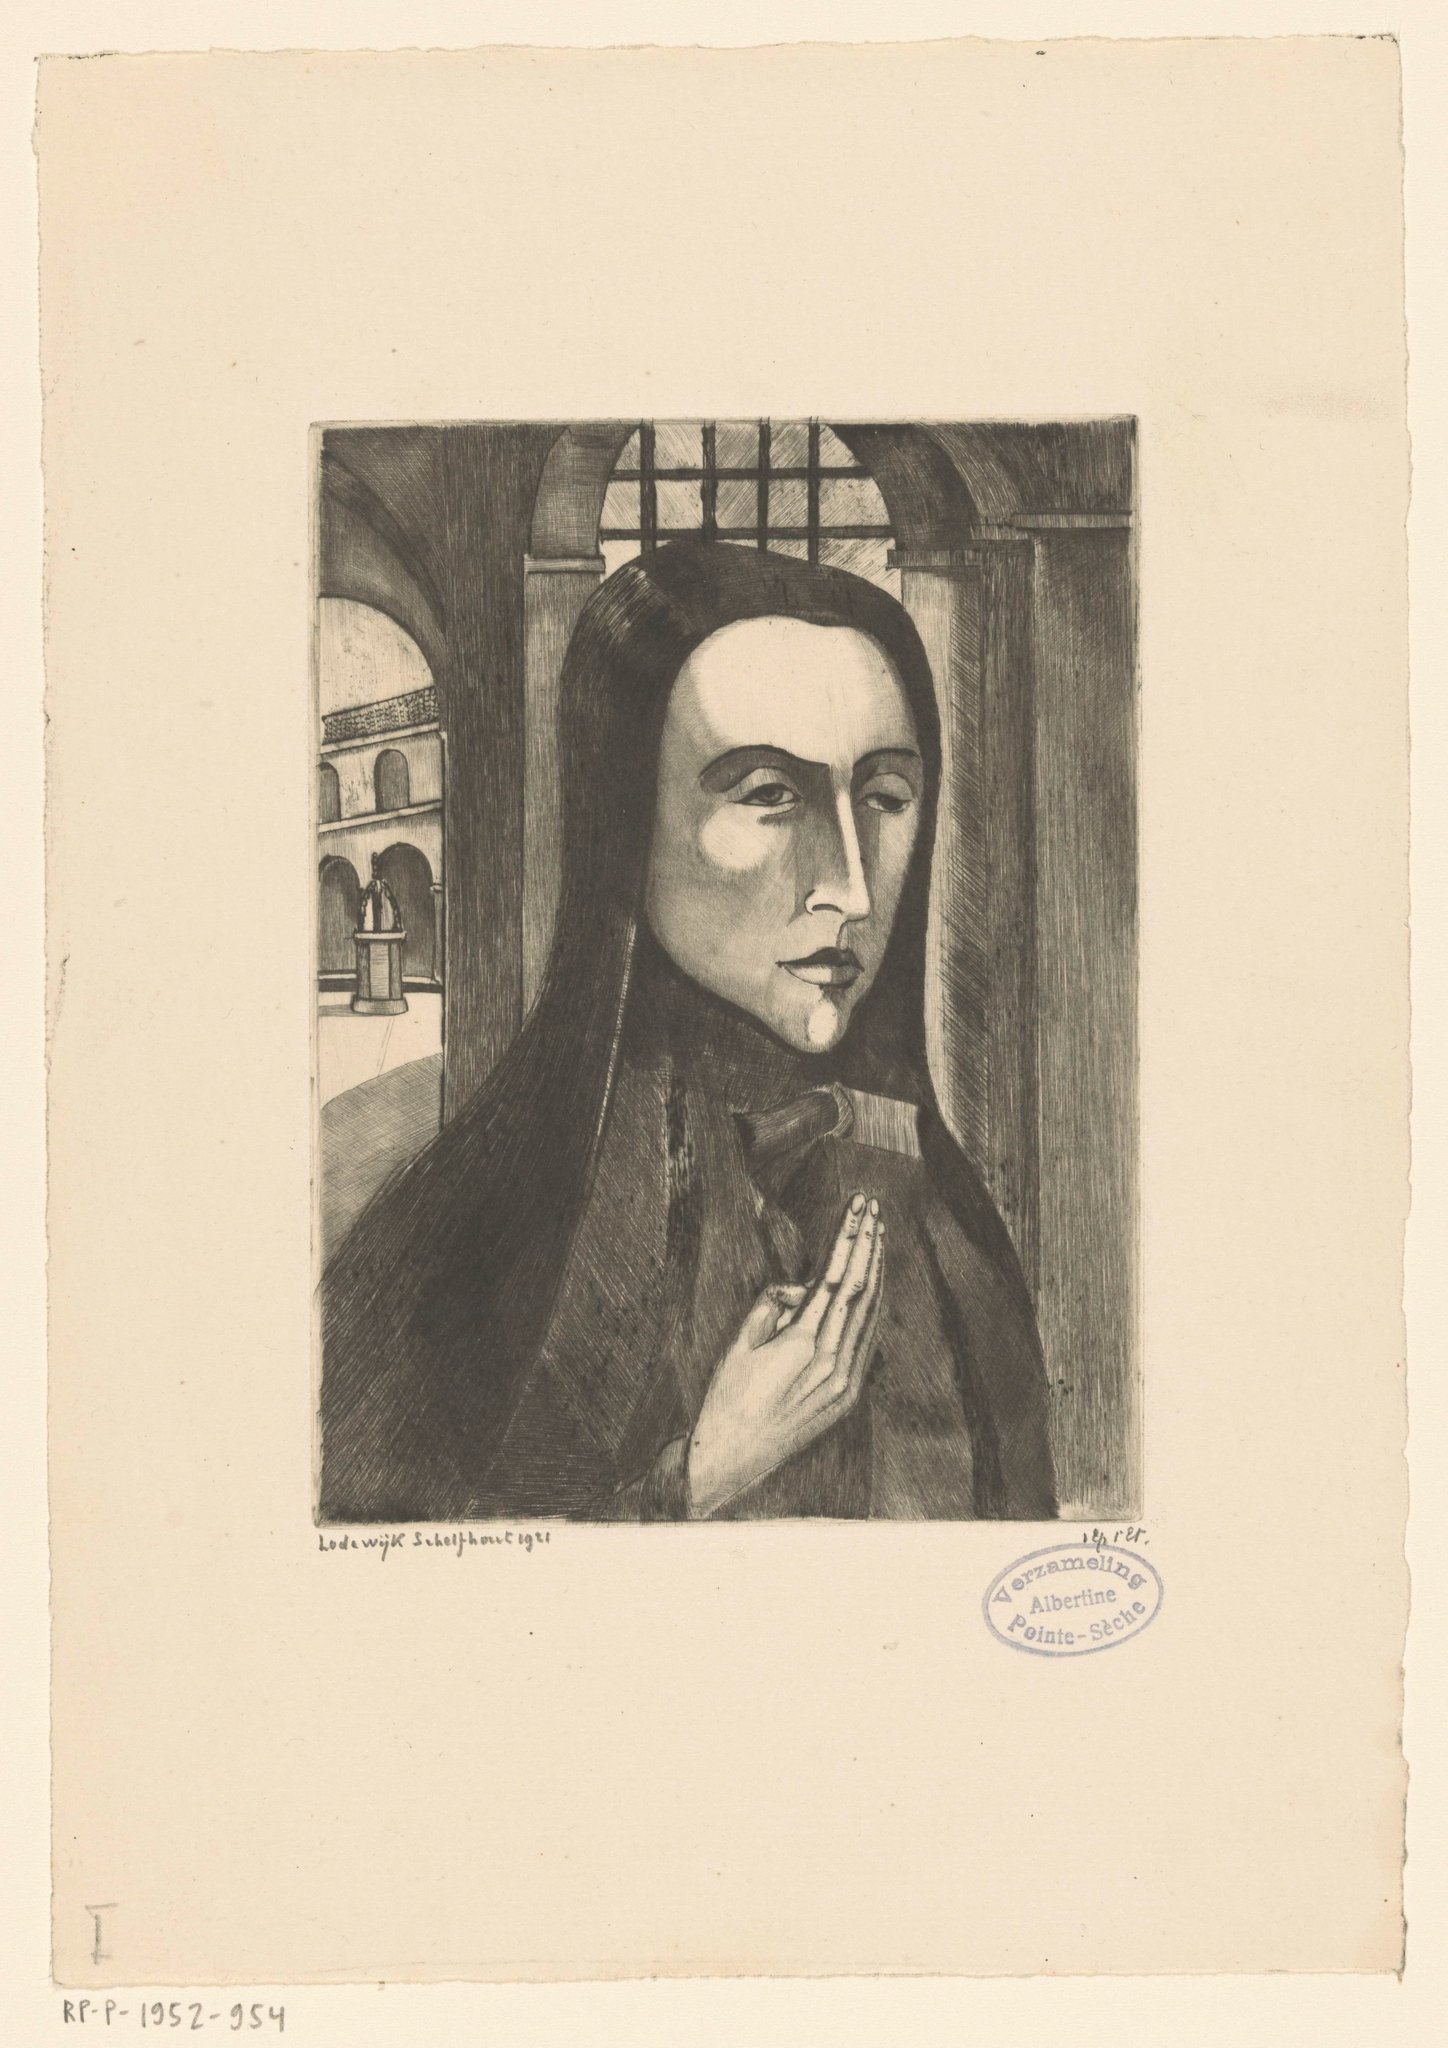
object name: print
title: Corsicaanse vrouw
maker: lodewijk schelfhout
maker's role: draughtsman, print maker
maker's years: 1881-1943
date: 1921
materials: paper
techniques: drypoint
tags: courtyard, veil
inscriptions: collector's mark: Lugt 2228, collector's mark: Lugt 2760, collector's mark: Lugt 5i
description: Een Corsicaanse vrouw met hoofddoek. Op de achtergrond een binnenplaats.